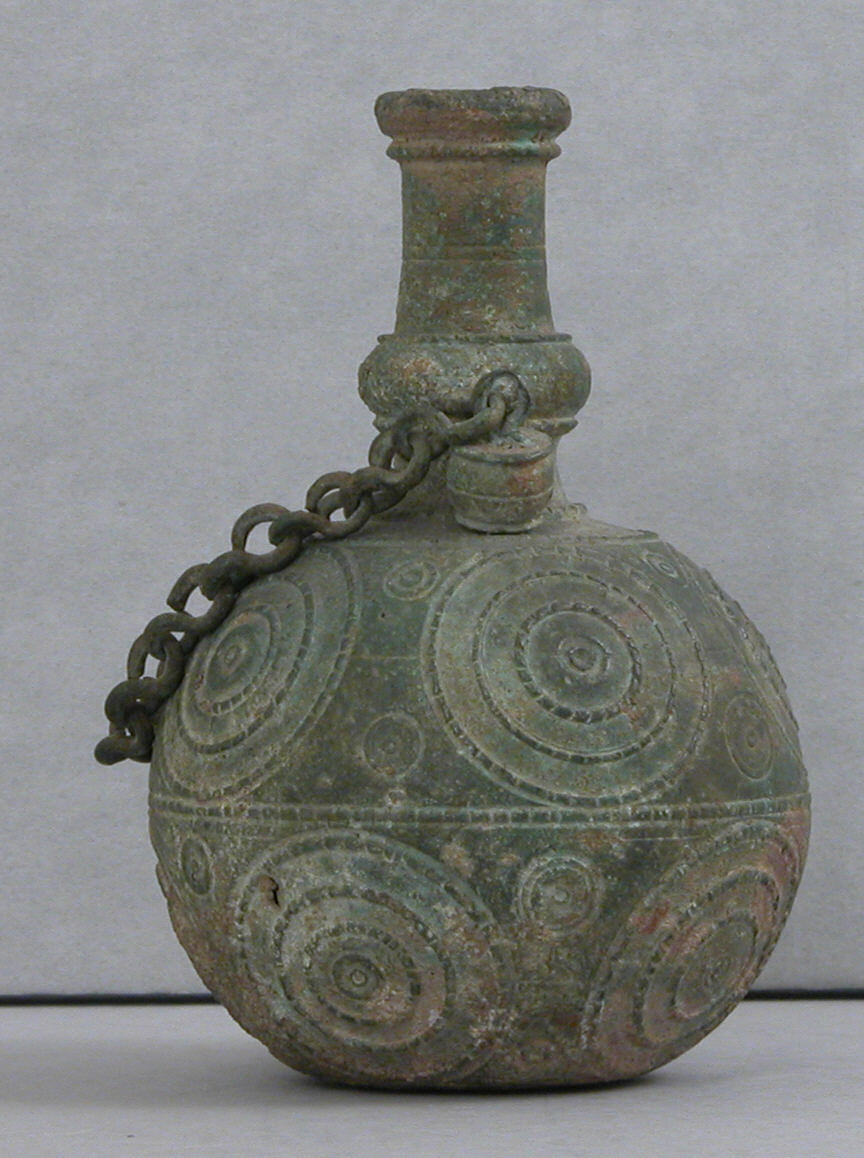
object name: bottle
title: Ointment Bottle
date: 601-800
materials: bronze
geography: syria